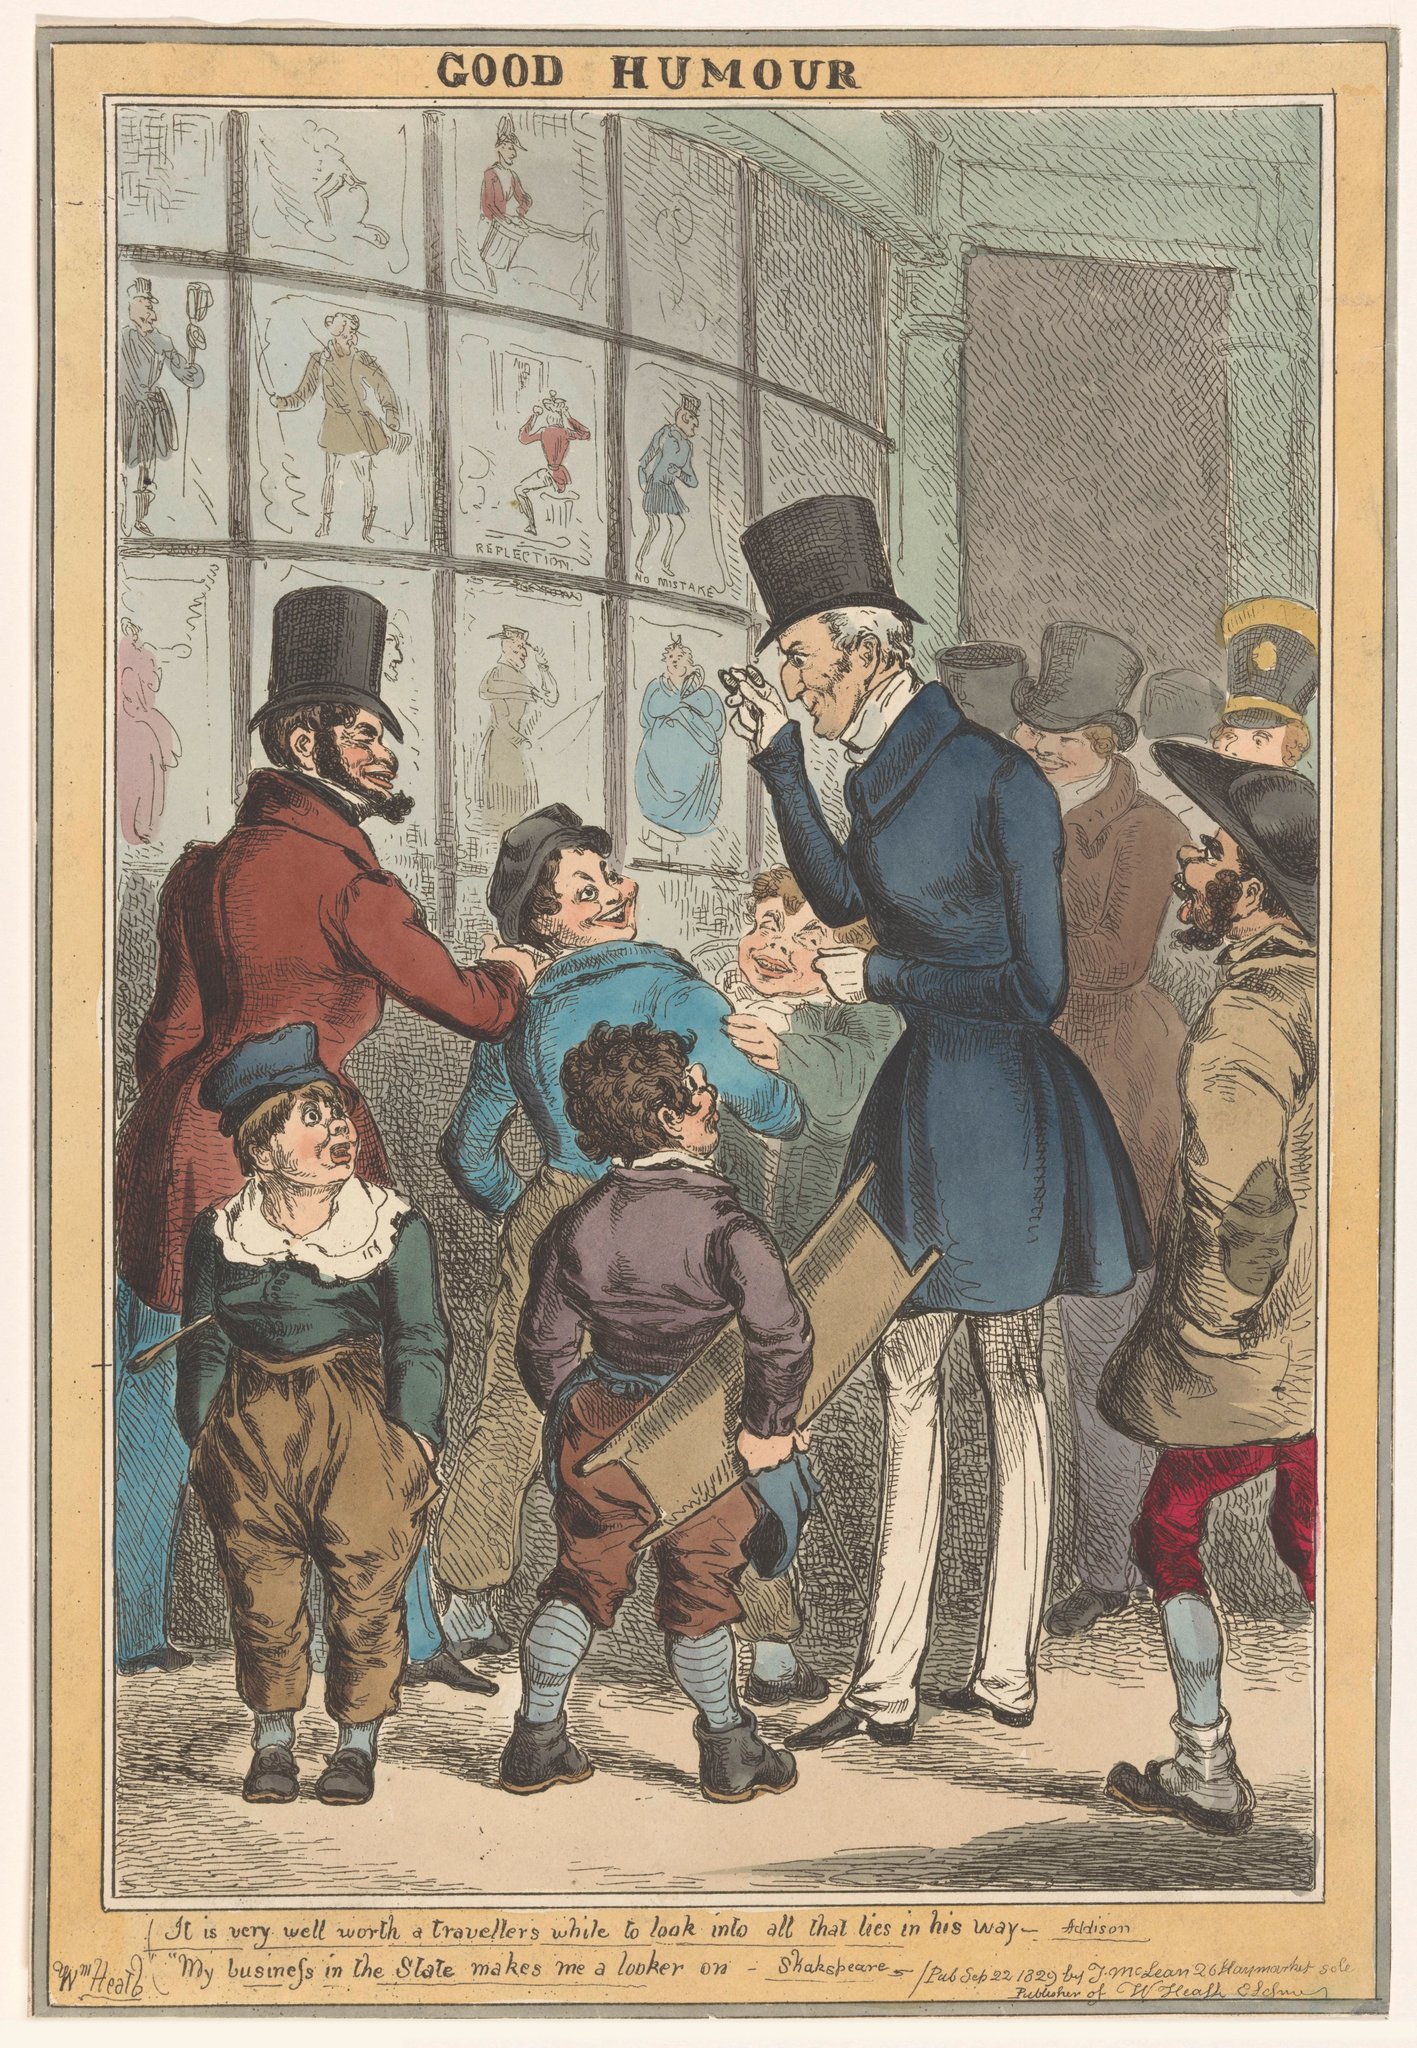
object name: print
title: Hertog van Wellington voor de etalage van Thomas McLean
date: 1809-1829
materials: paper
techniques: etching, hand coloring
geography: london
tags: walmer castle, arthur wellesley of wellington, caricatures (human types), publishing, publisher, shop-window, show-window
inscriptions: collector's mark: Lugt 4780, collector's mark: Lugt 4779, collector's mark: Lugt 2228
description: De hertog van Wellington, in blauwe jas, witte broek en hoge hoed, kijkt door een bril naar spotprenten van hemzelf in de etalage van Thomas McLean, uitgever van prenten. Hij wordt omringd door kinderen en volwassenen.